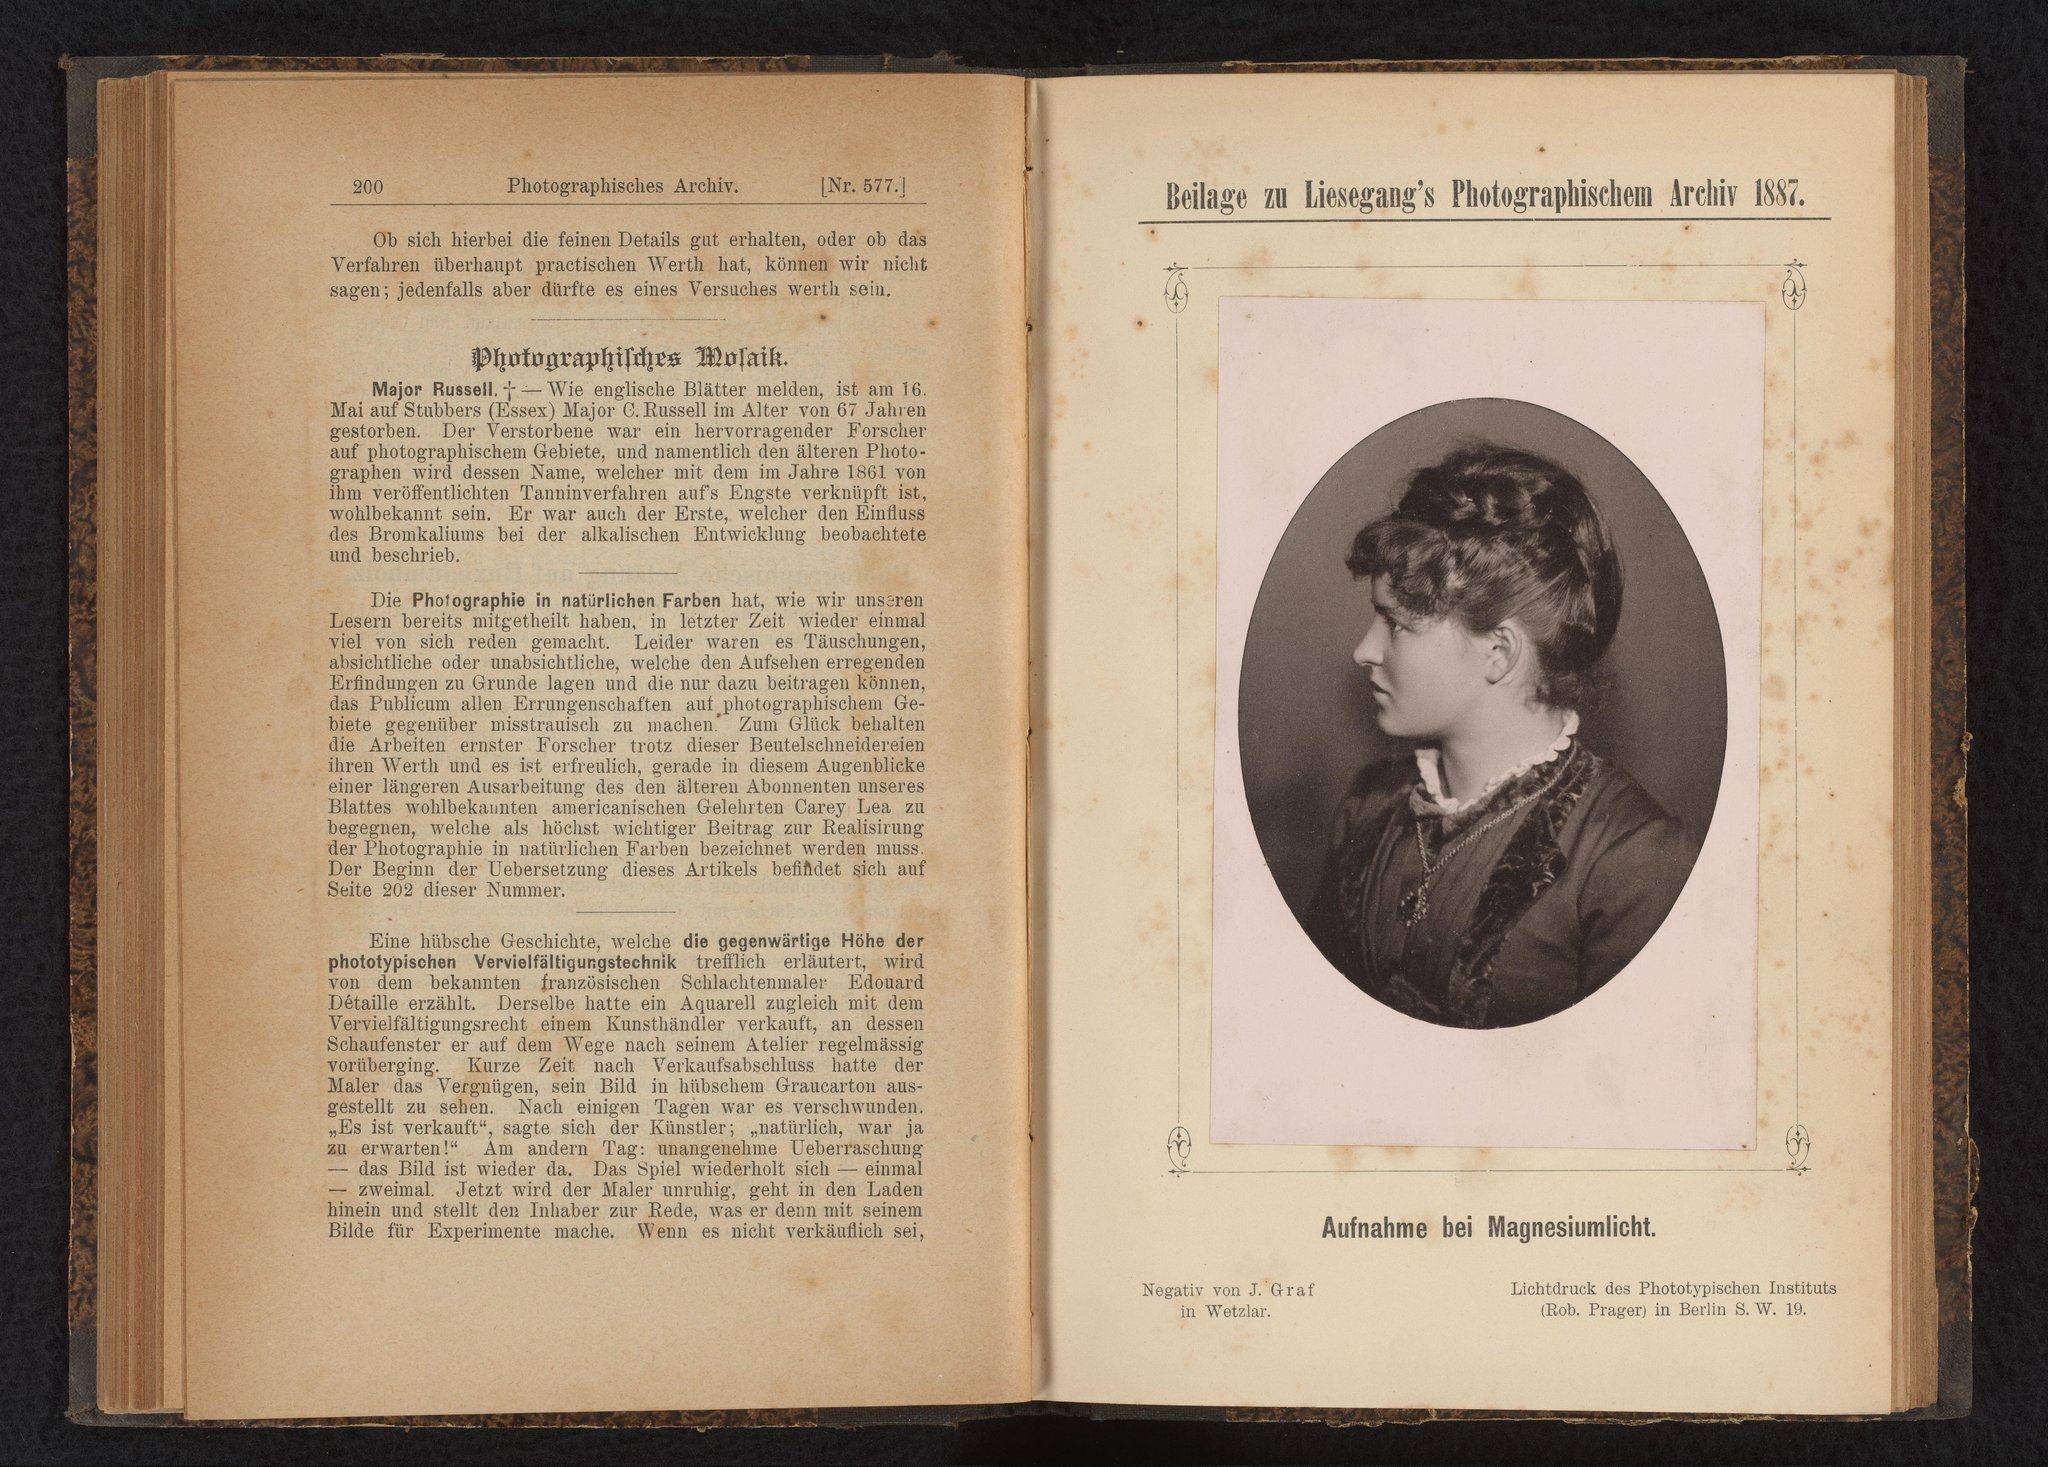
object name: page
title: Aufnahme bei Magnesiumlicht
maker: j. graf (fotograaf)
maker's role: fotograaf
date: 1882-1887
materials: paper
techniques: photograph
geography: wetzlar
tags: historical persons not known by name - bb - woman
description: Prent op ongenummerde pagina tegenover pagina 200.